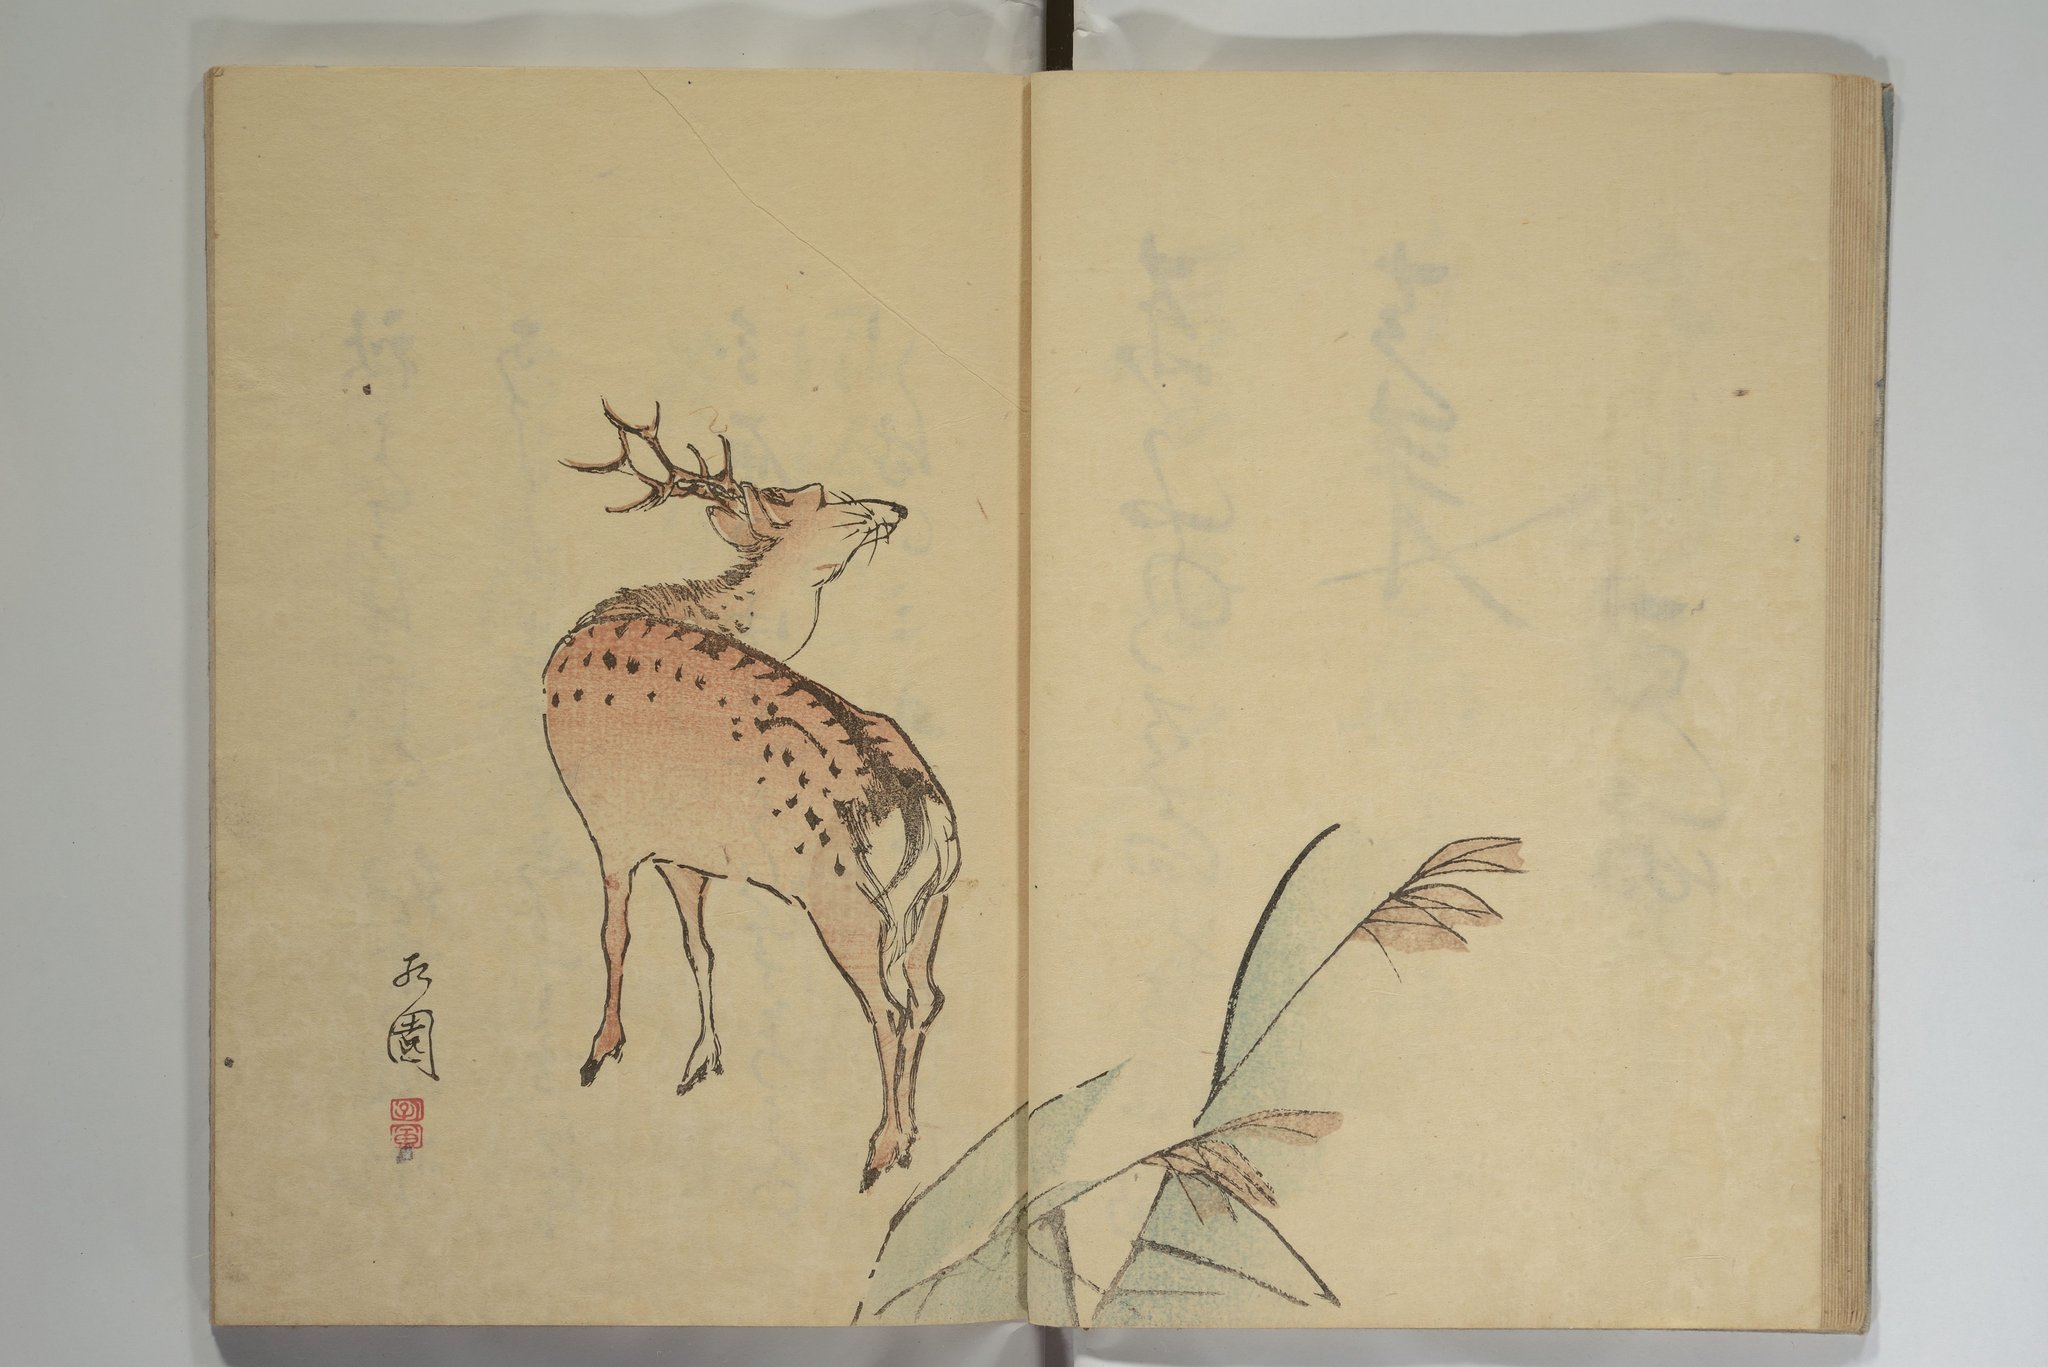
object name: illustrated book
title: The Nanpo Album (Nanpo jō) 南畝帖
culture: japanese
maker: nagayama kōin (hirotora) 長山孔寅画・蜀山人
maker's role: artist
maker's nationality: japanese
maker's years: 1765-1849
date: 1824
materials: ink, paper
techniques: woodblock print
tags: deer